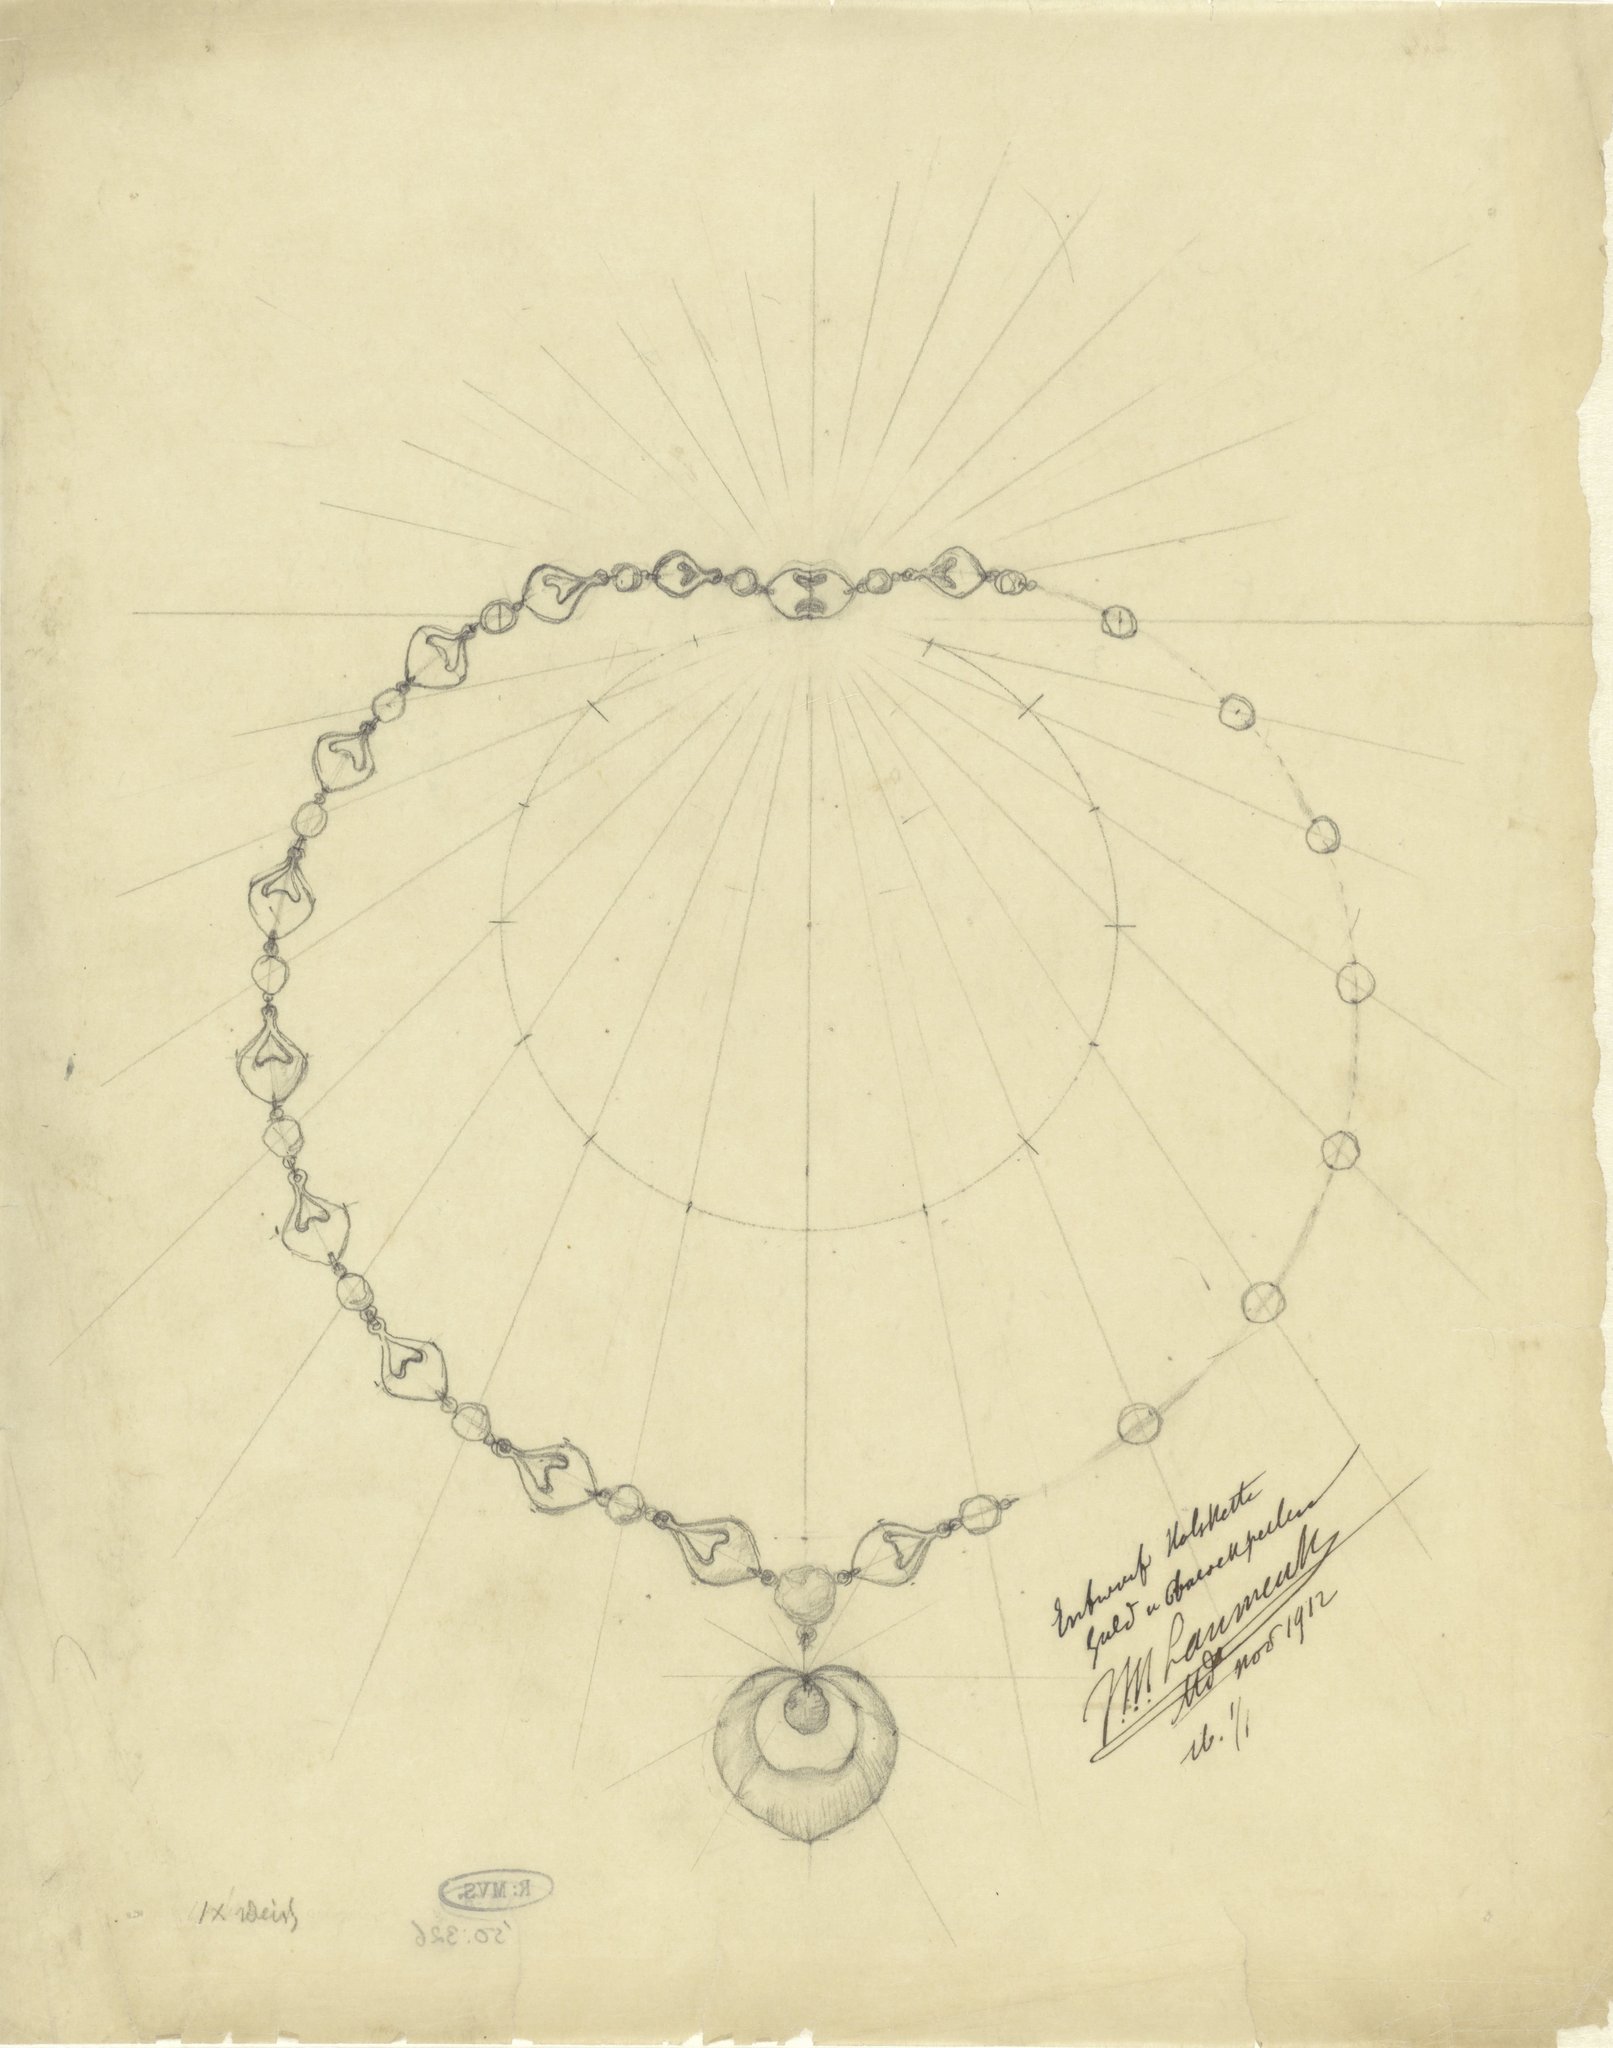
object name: drawing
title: Ontwerp voor een halsketting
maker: mathieu lauweriks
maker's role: designer, draughtsman, print maker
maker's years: 1864-1932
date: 1911-1912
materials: pencil, paper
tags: necklace (+ women's clothes)